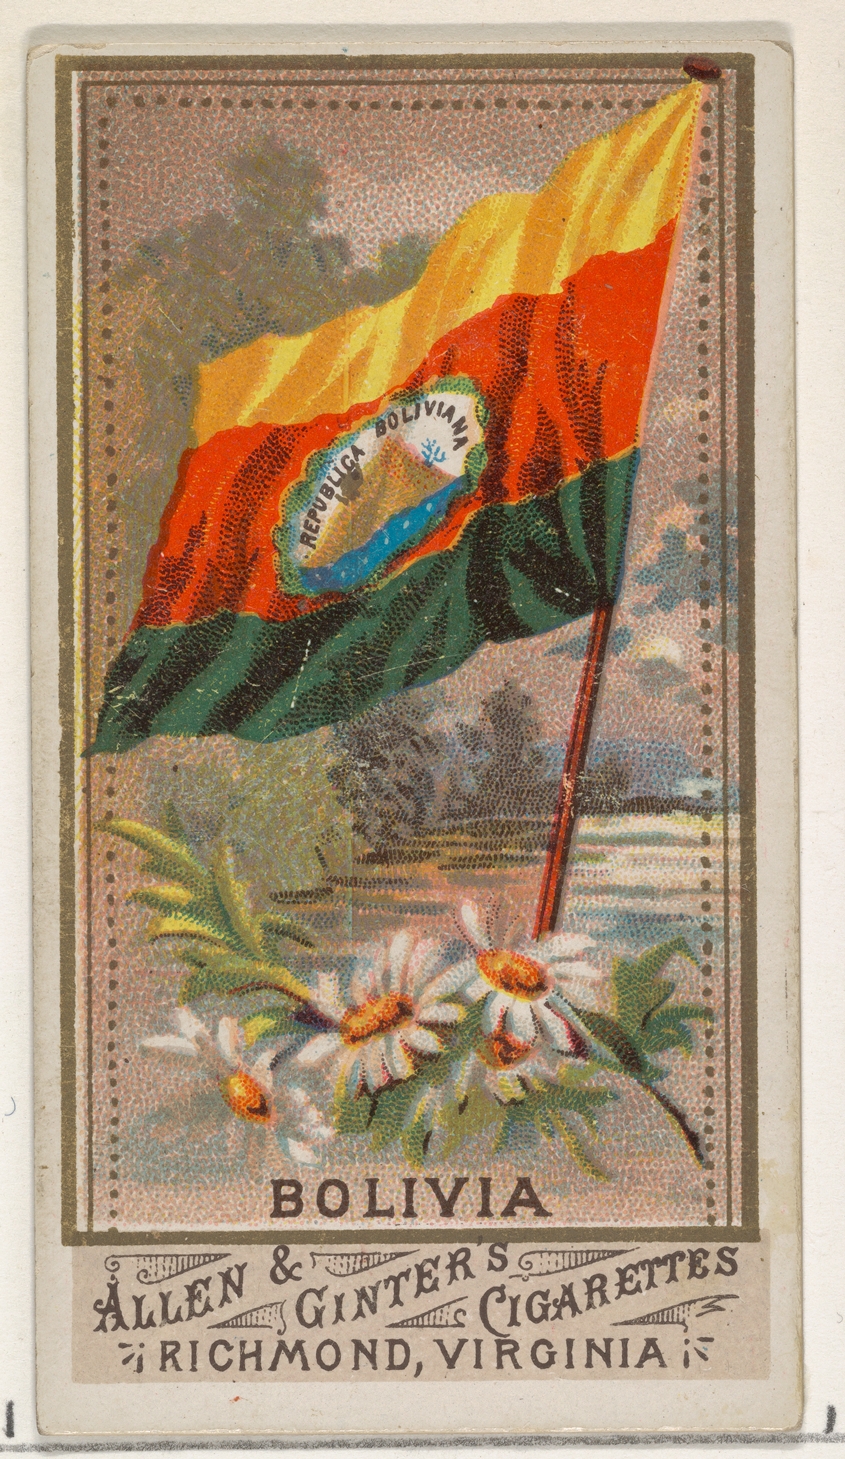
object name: print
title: Bolivia, from Flags of All Nations, Series 1 (N9) for Allen & Ginter Cigarettes Brands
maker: allen & ginter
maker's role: publisher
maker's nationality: american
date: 1887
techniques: color lithograph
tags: flags